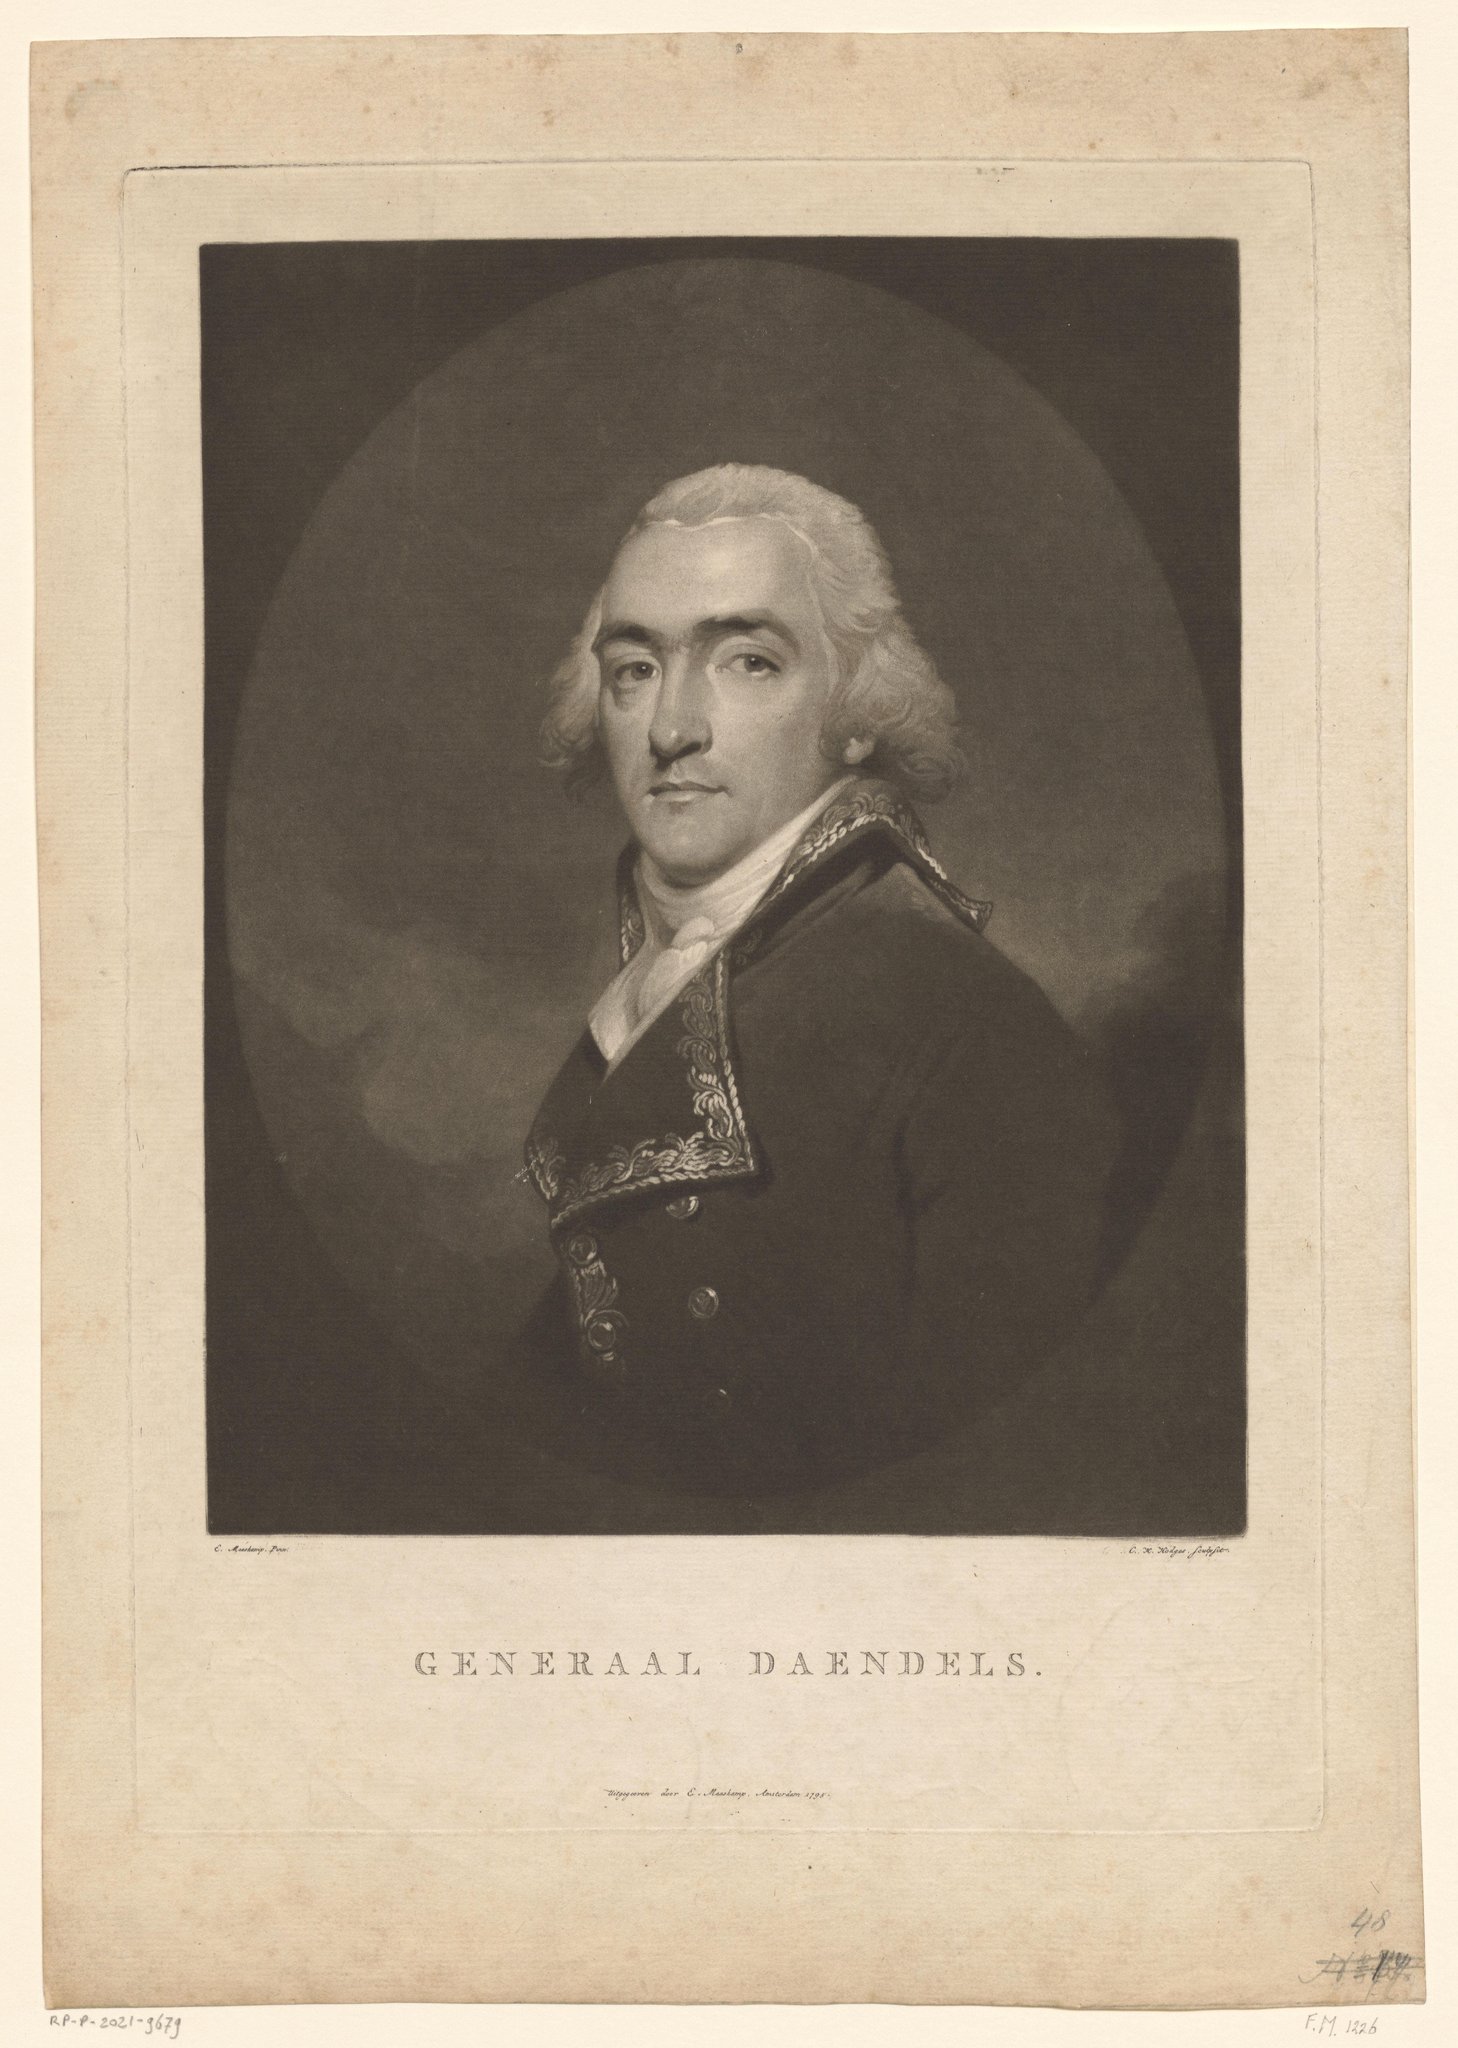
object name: print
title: Portret van Herman Willem Daendels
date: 1795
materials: paper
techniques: engraving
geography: amsterdam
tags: herman willem daendels, commander-in-chief, general, marshal, historical persons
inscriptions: collector's mark: Lugt 2228